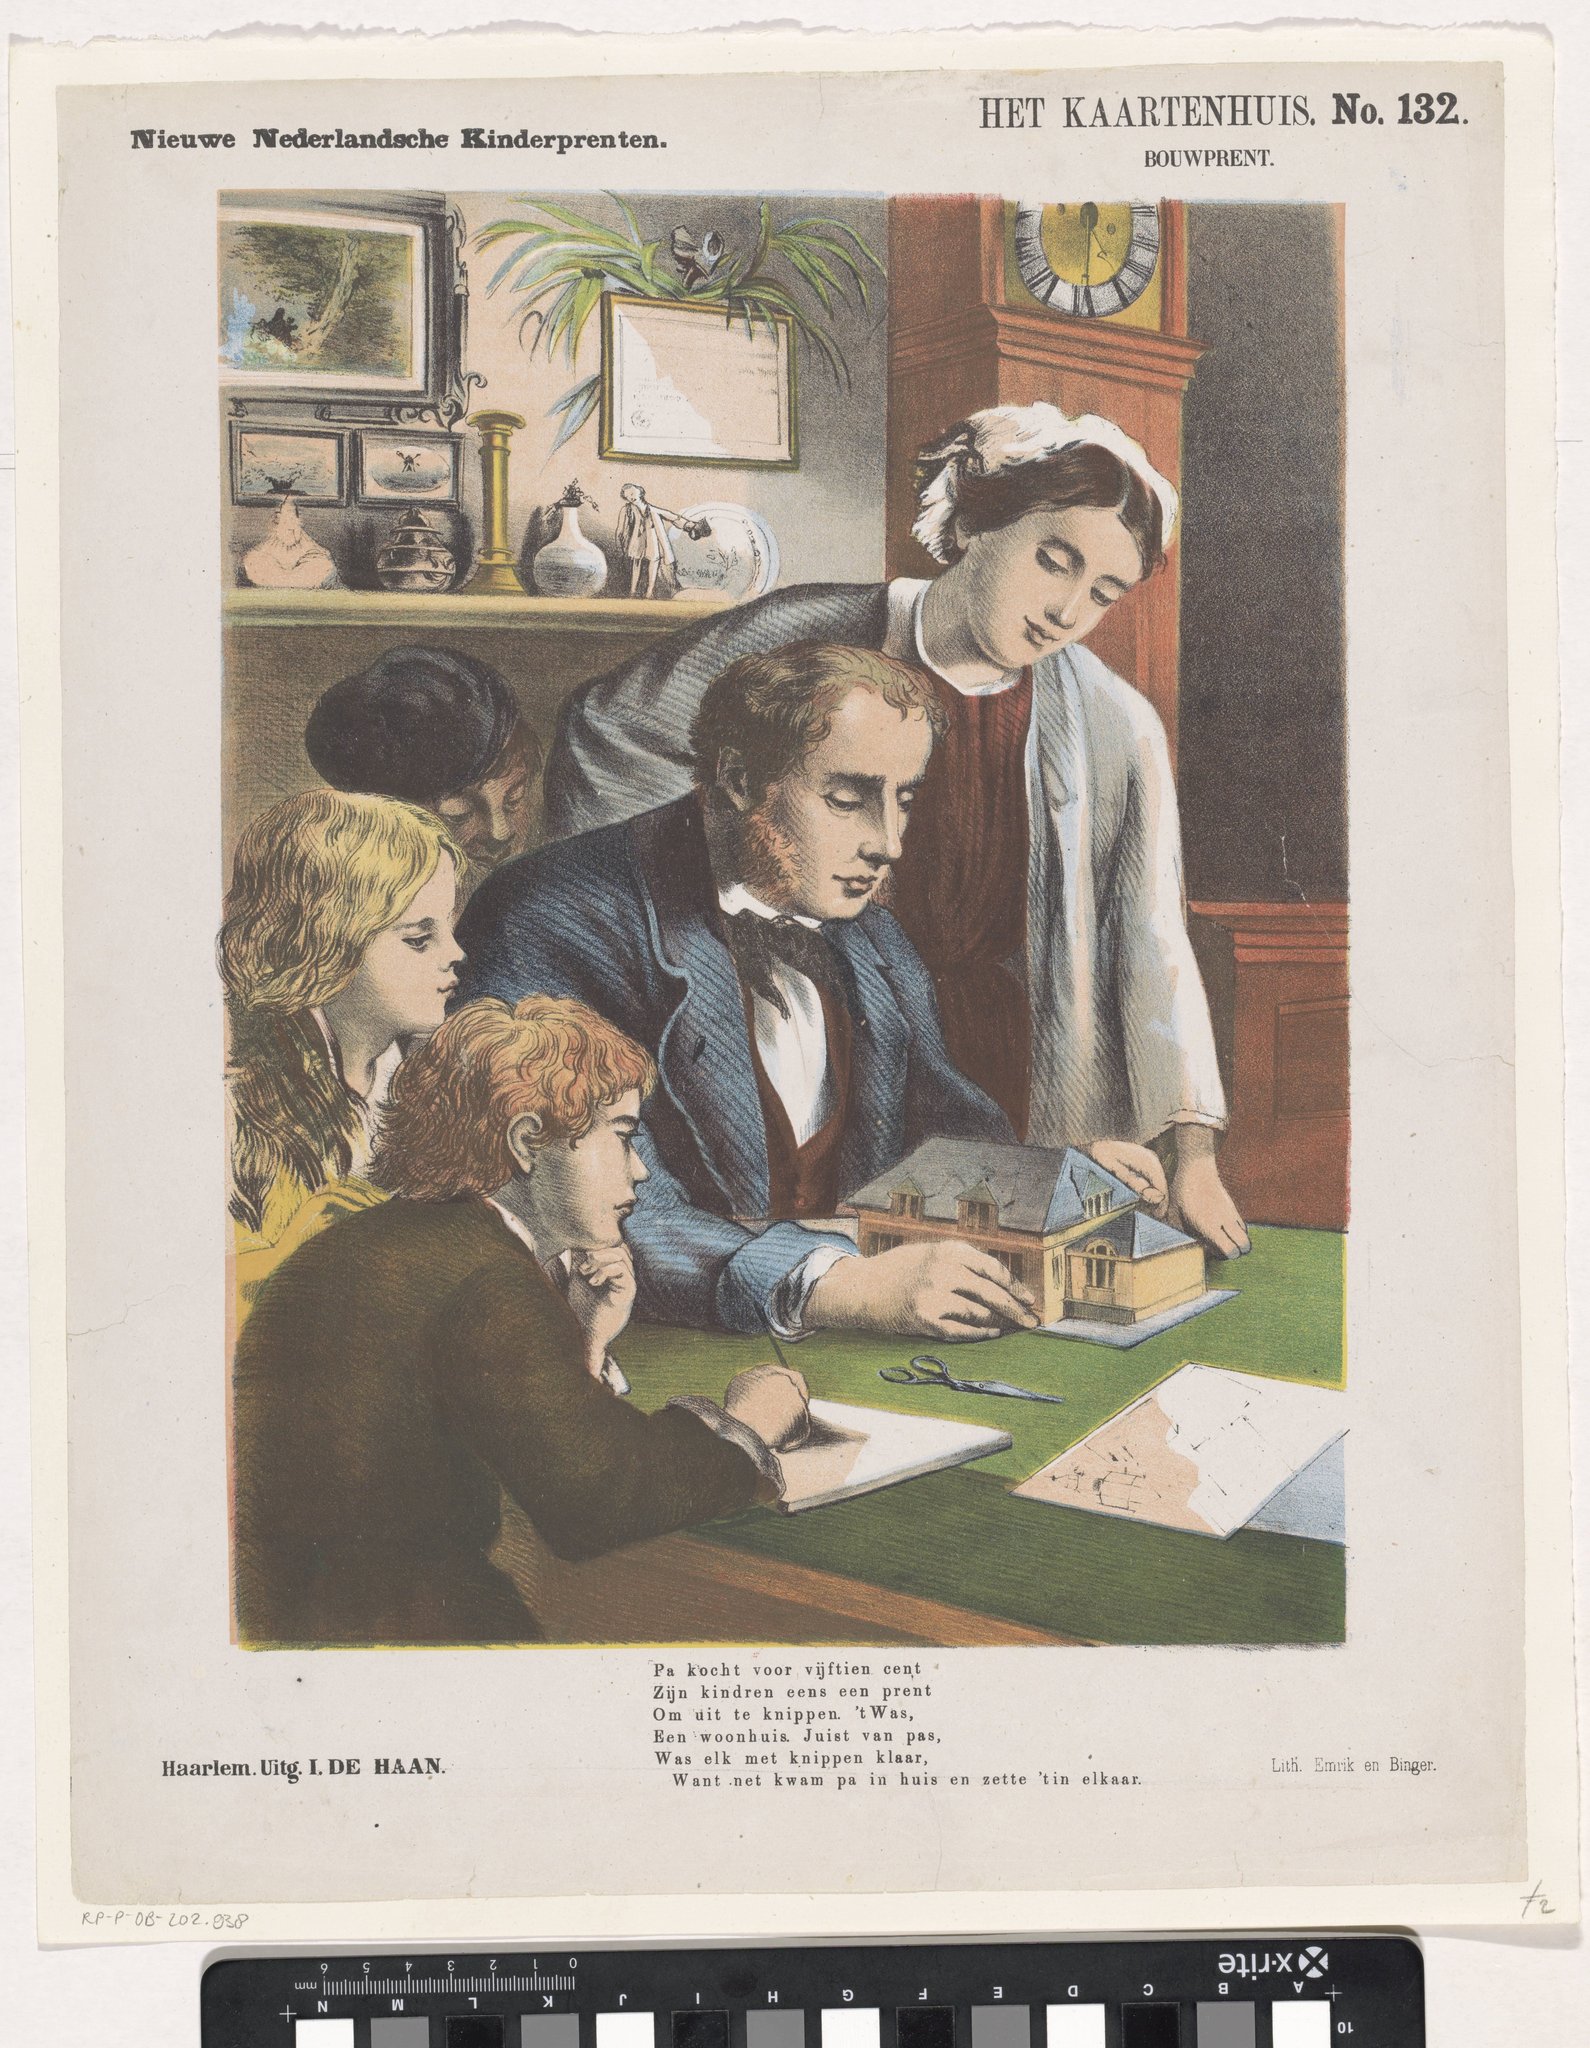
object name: popular print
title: Nieuwe Nederlandsche kinderprenten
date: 1875-1903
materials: paper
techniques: lithograph, letterpress printing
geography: haarlem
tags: family life at home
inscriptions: collector's mark: Lugt 2760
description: Blad met grote voorstelling van een gezin aan een tafel. De vader van het gezin bouwt een huis van een bouwprent. De moeder en de kinderen kijken toe. Onder de afbeelding een vers. Genummerd rechtsboven: No. 132.